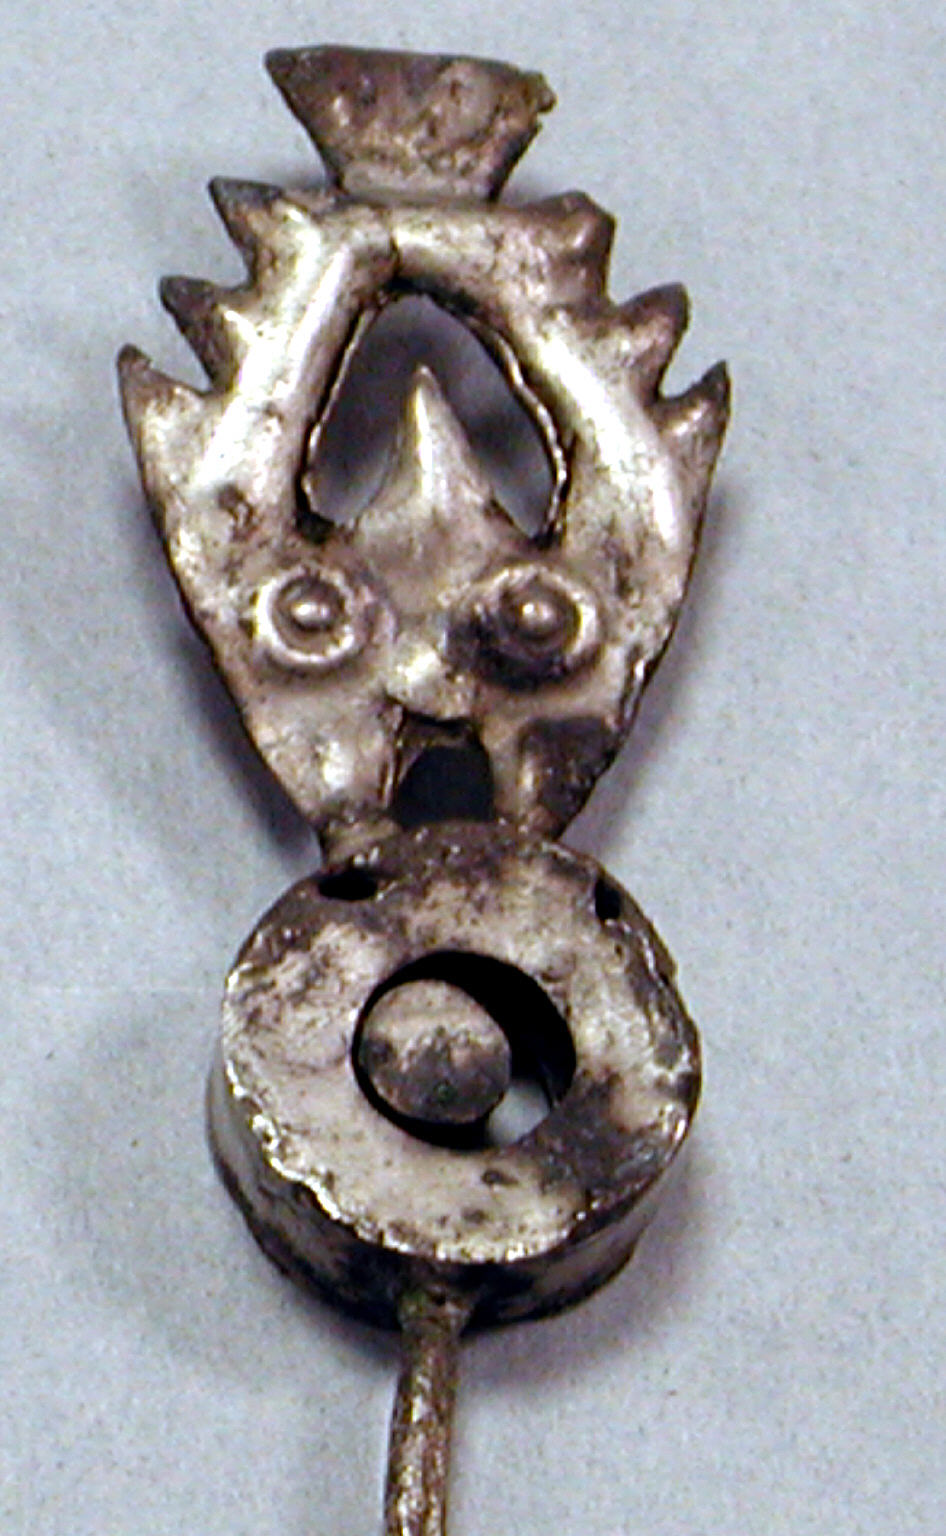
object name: pin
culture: chimú or inca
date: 1401-1600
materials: silver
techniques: hammering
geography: peru